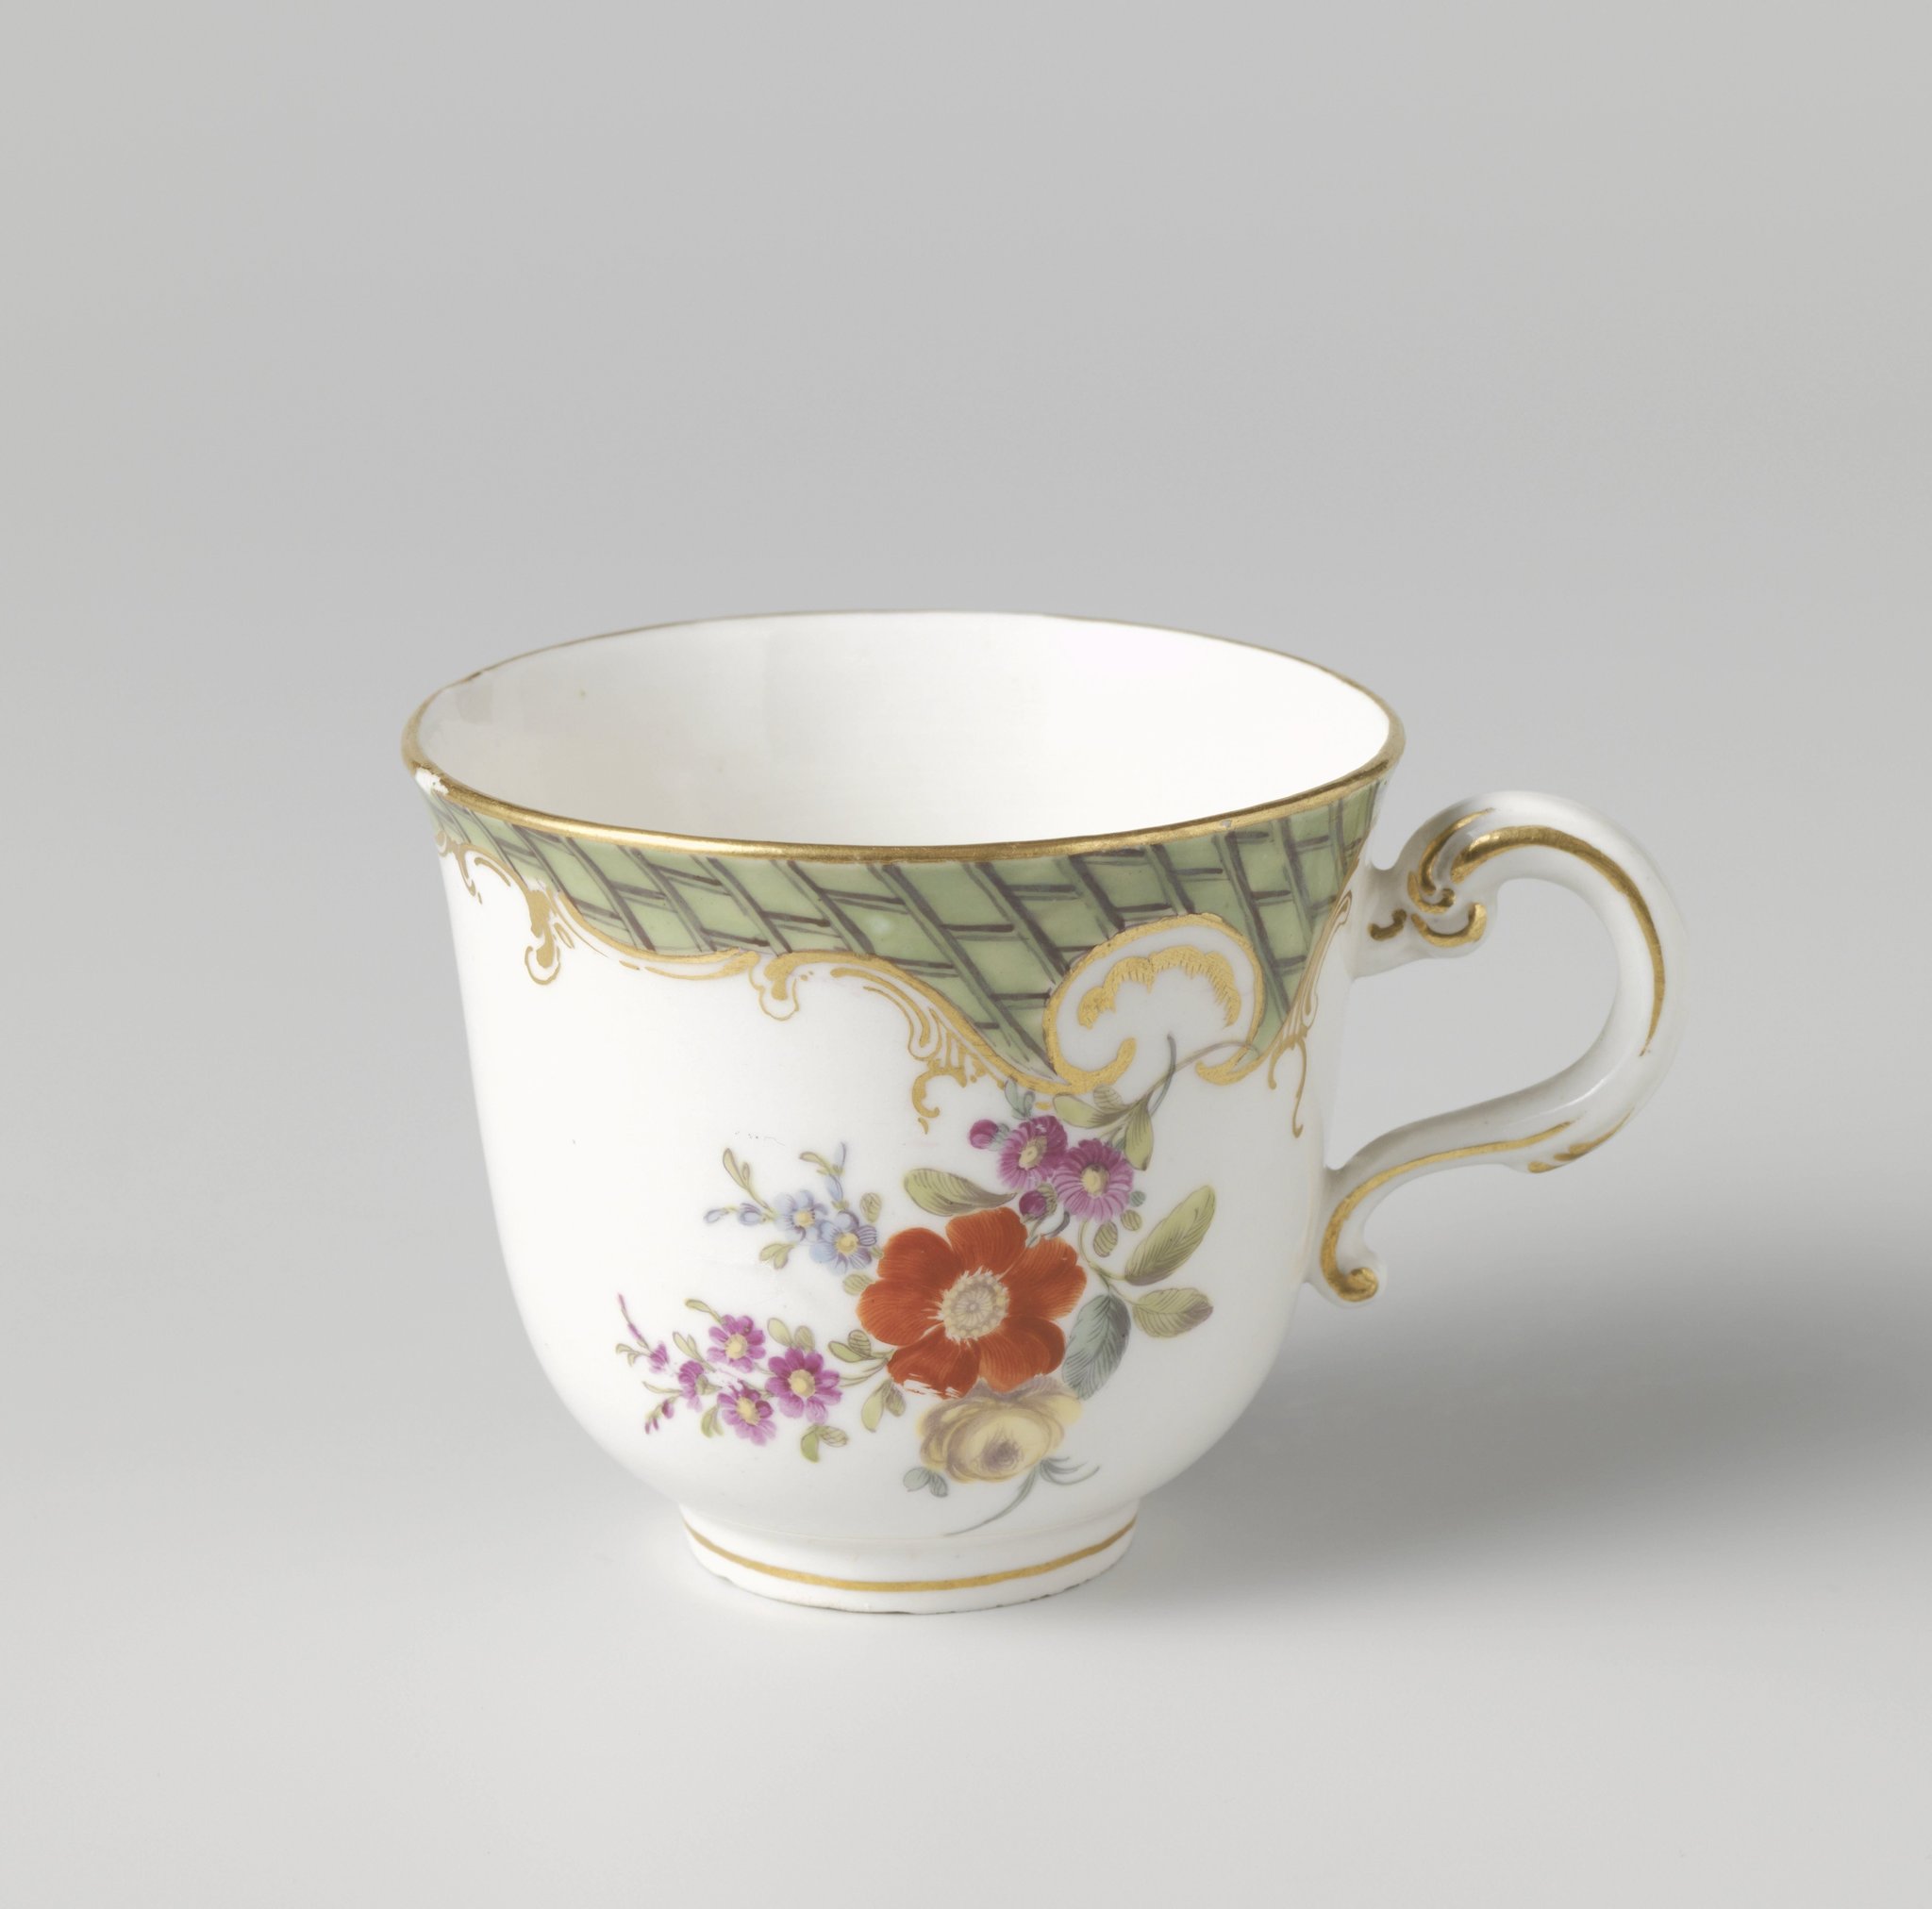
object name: cup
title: Kop met oor, beschilderd met bloemen en laddermotief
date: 1775-1778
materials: porcelain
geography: loosdrecht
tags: flowers ~ ornament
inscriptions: mark: ‘Lm3’, factory mark: ‘M:OL’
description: Kop met oor van porselein. Veelkleurig beschilderd met bloemboeketten en een laddermotief langs de randen.